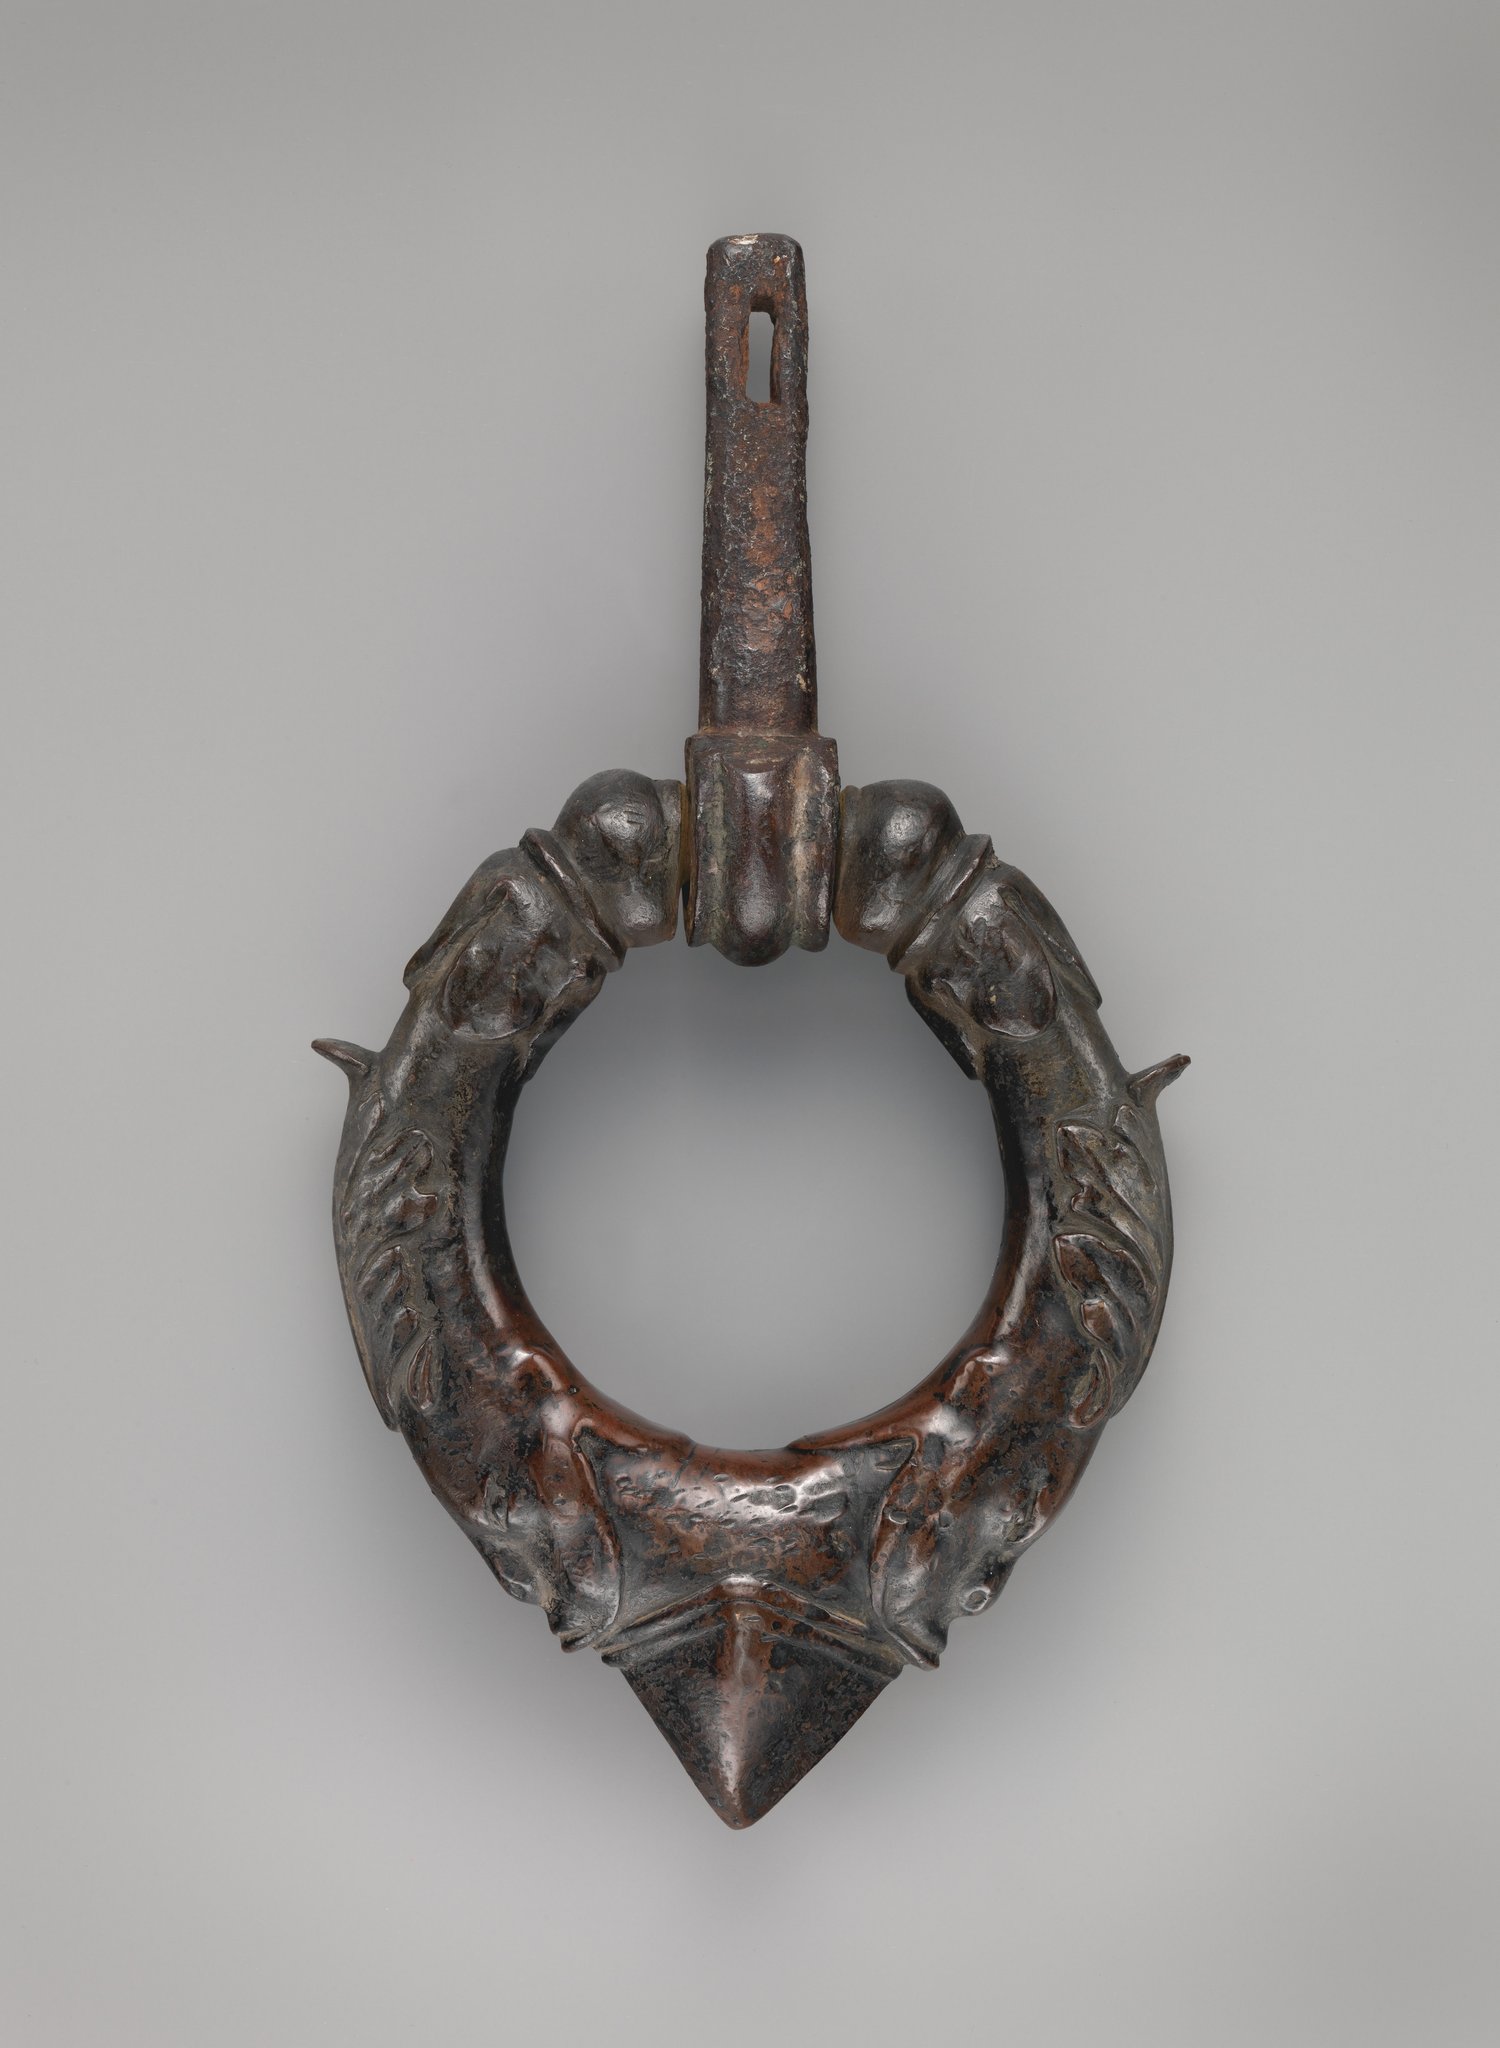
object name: door knocker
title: Doorknocker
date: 1467-1533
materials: bronze, iron